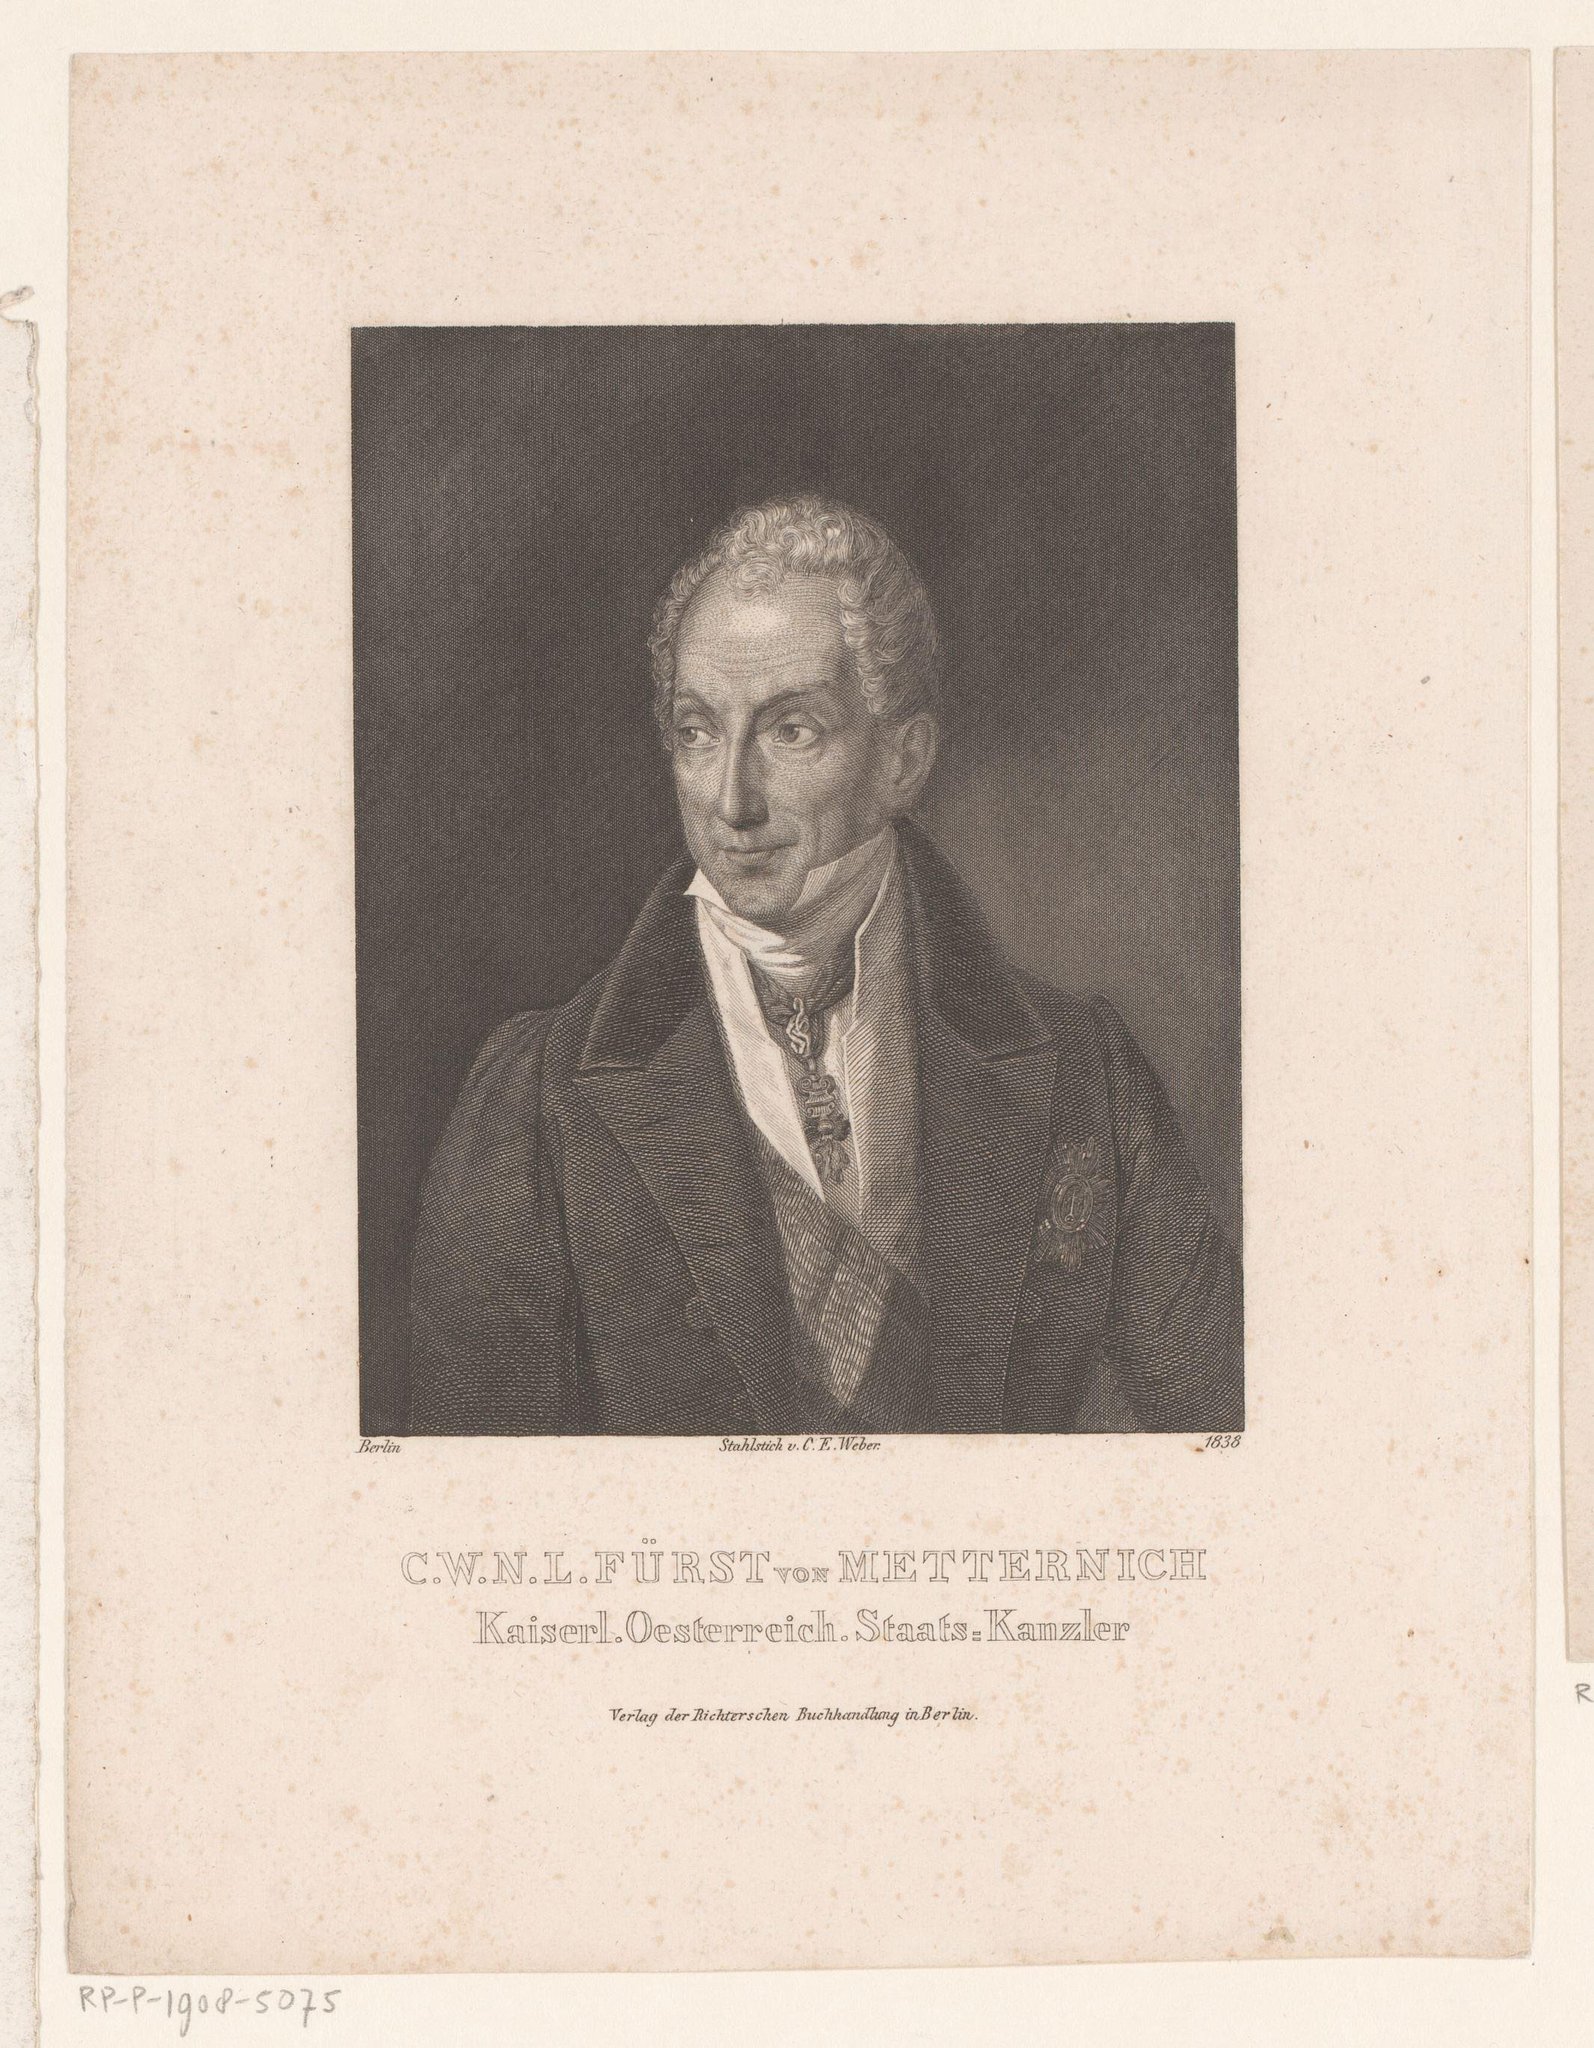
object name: print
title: Portret van Klemens Wenzel Lothar, Fürst von Metternich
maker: karl eduard weber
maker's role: draughtsman, painter, print maker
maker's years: 1806-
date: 1838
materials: paper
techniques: engraving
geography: berlin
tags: vienna, historical persons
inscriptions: collector's mark: Lugt 2228